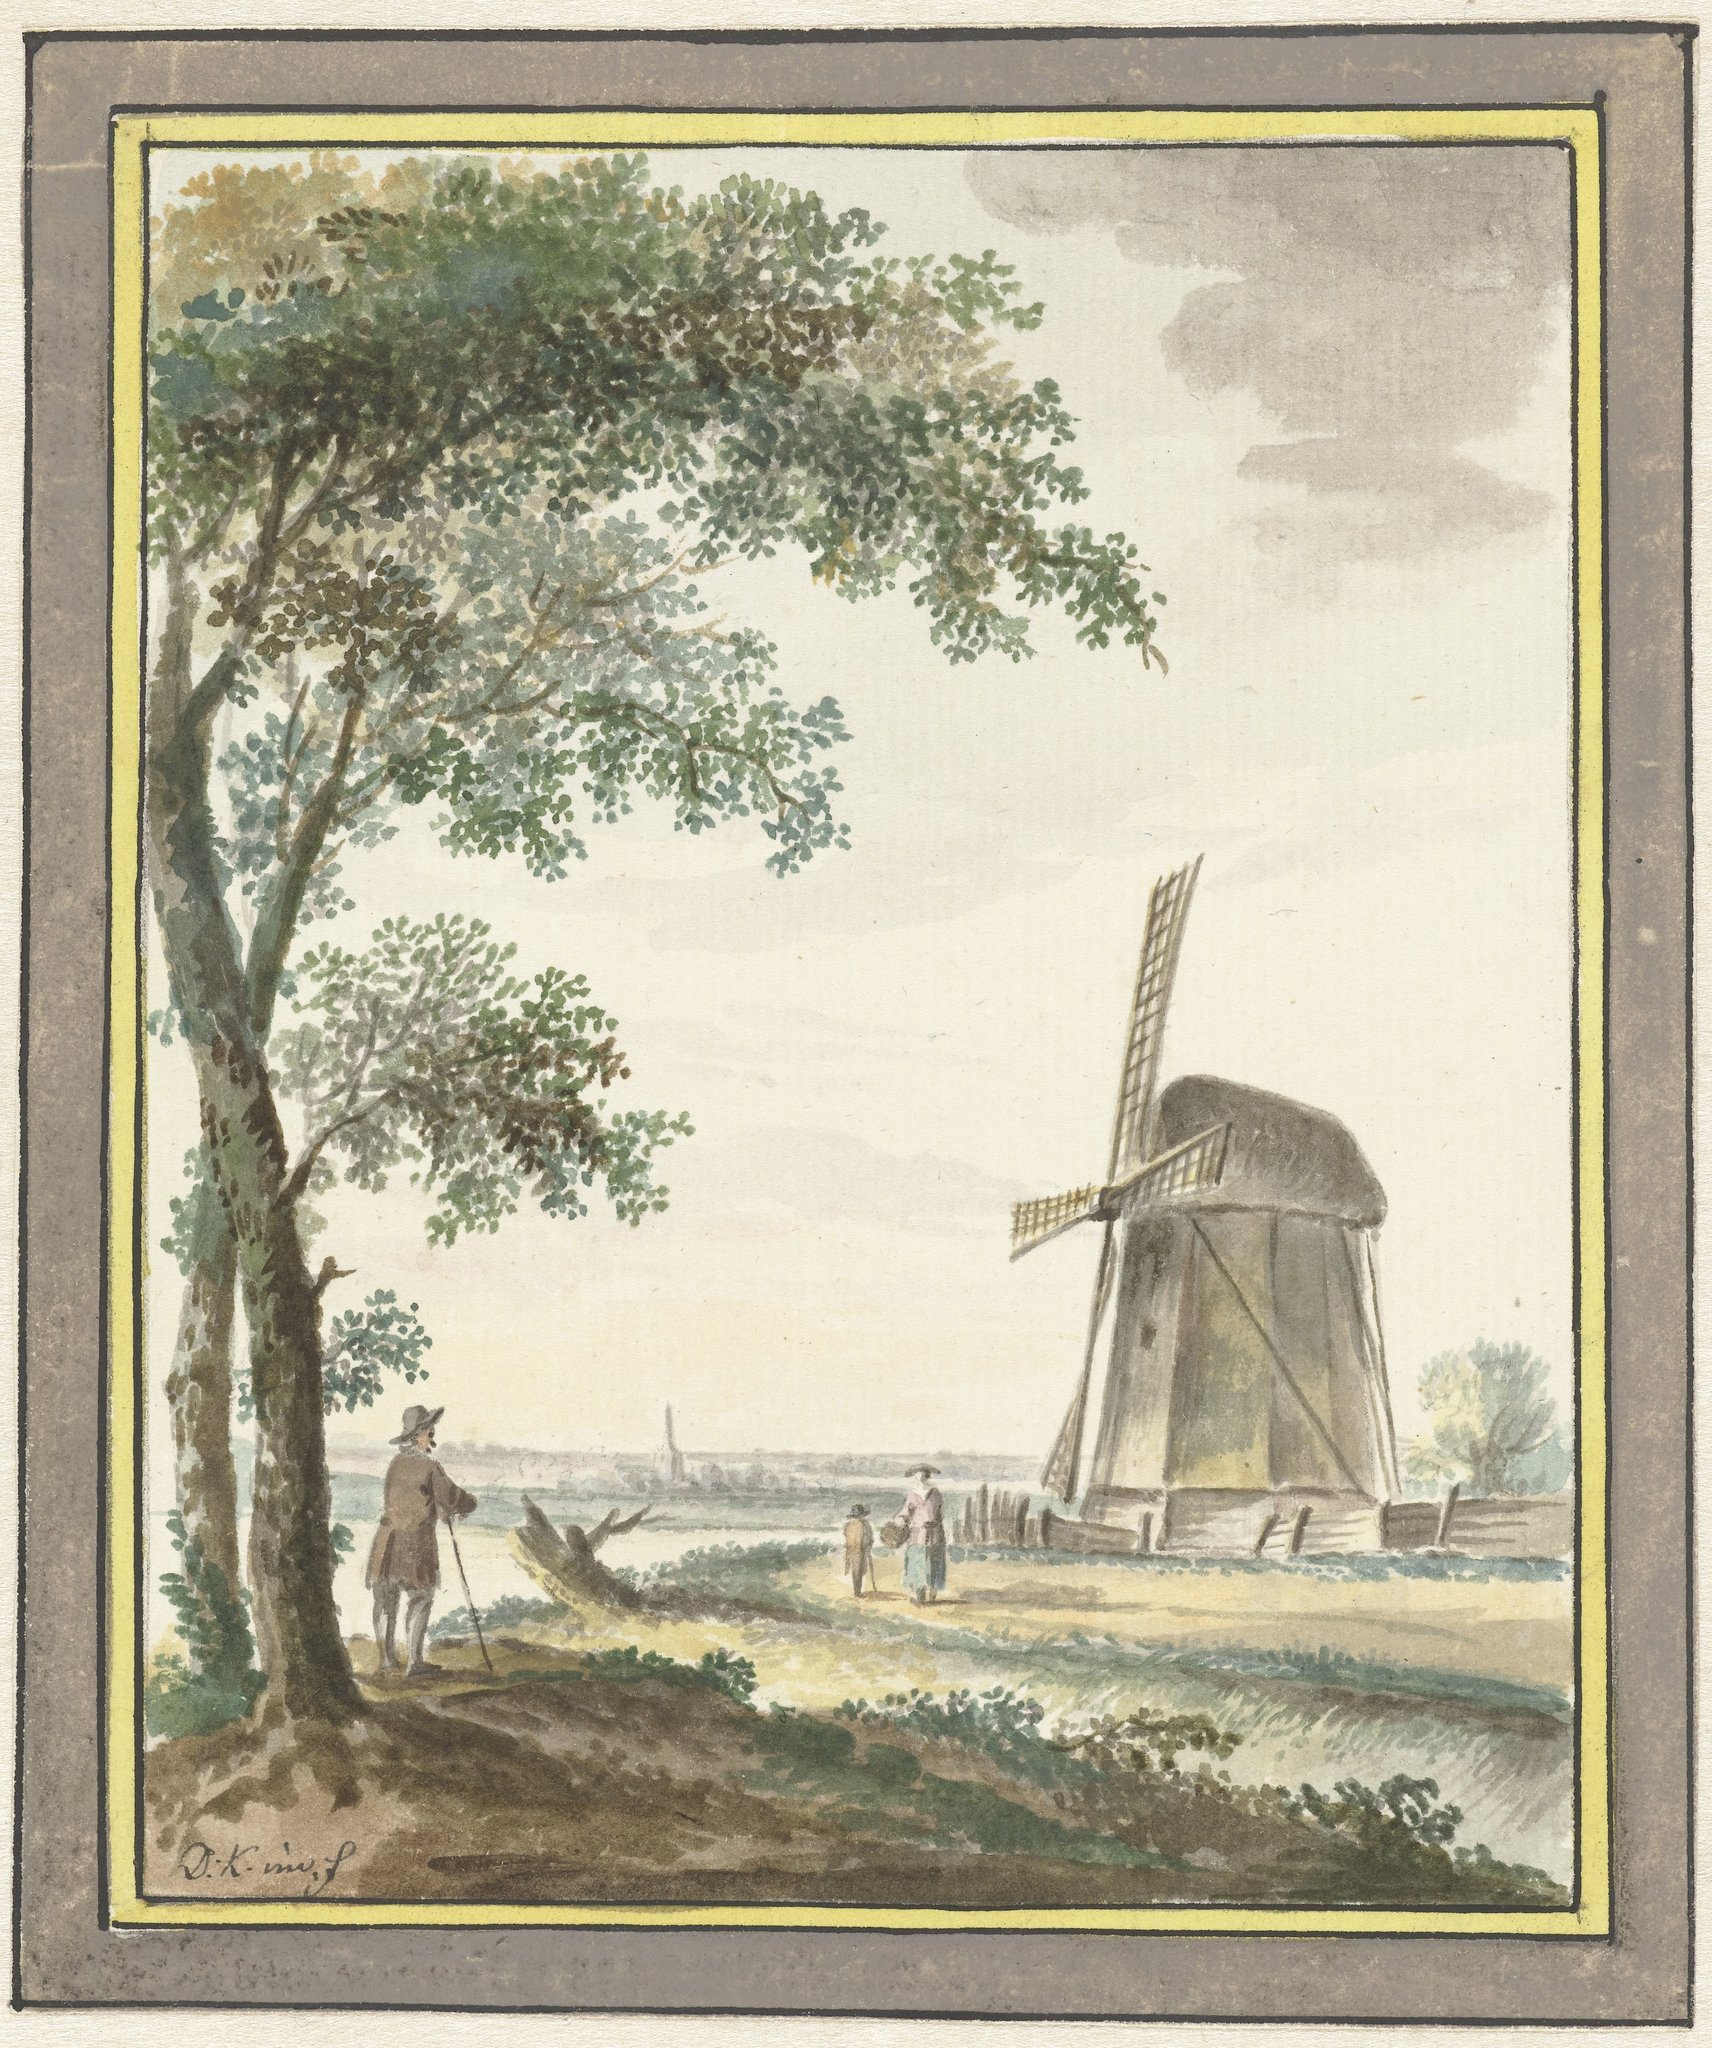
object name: watercolor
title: Landschap met molen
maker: dirk kuipers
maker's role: draughtsman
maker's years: 1733-1796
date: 1743-1796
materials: paper, watercolor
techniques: brush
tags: windmill in landscape